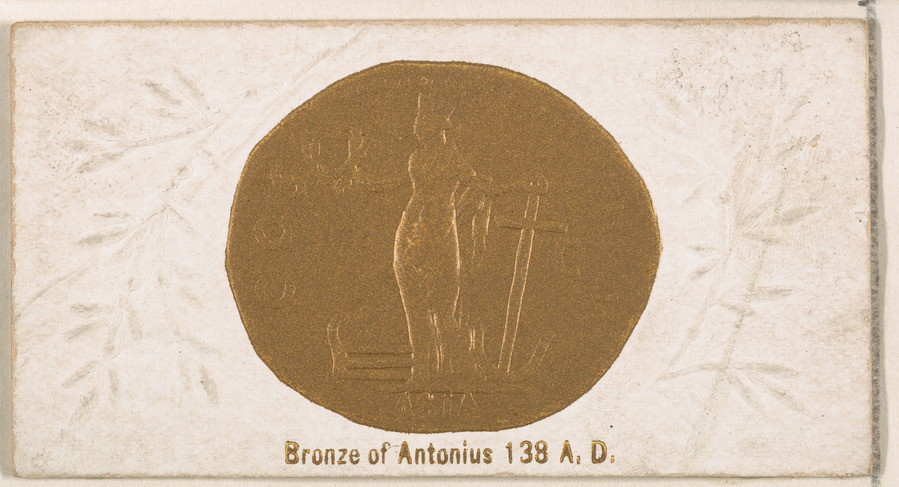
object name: print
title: Bronze of Antonius, 138 A.D., from the Ancient Coins series (N180) issued by Wm. S. Kimball & Co.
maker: william s. kimball & company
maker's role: publisher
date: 1888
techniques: color lithograph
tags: coins